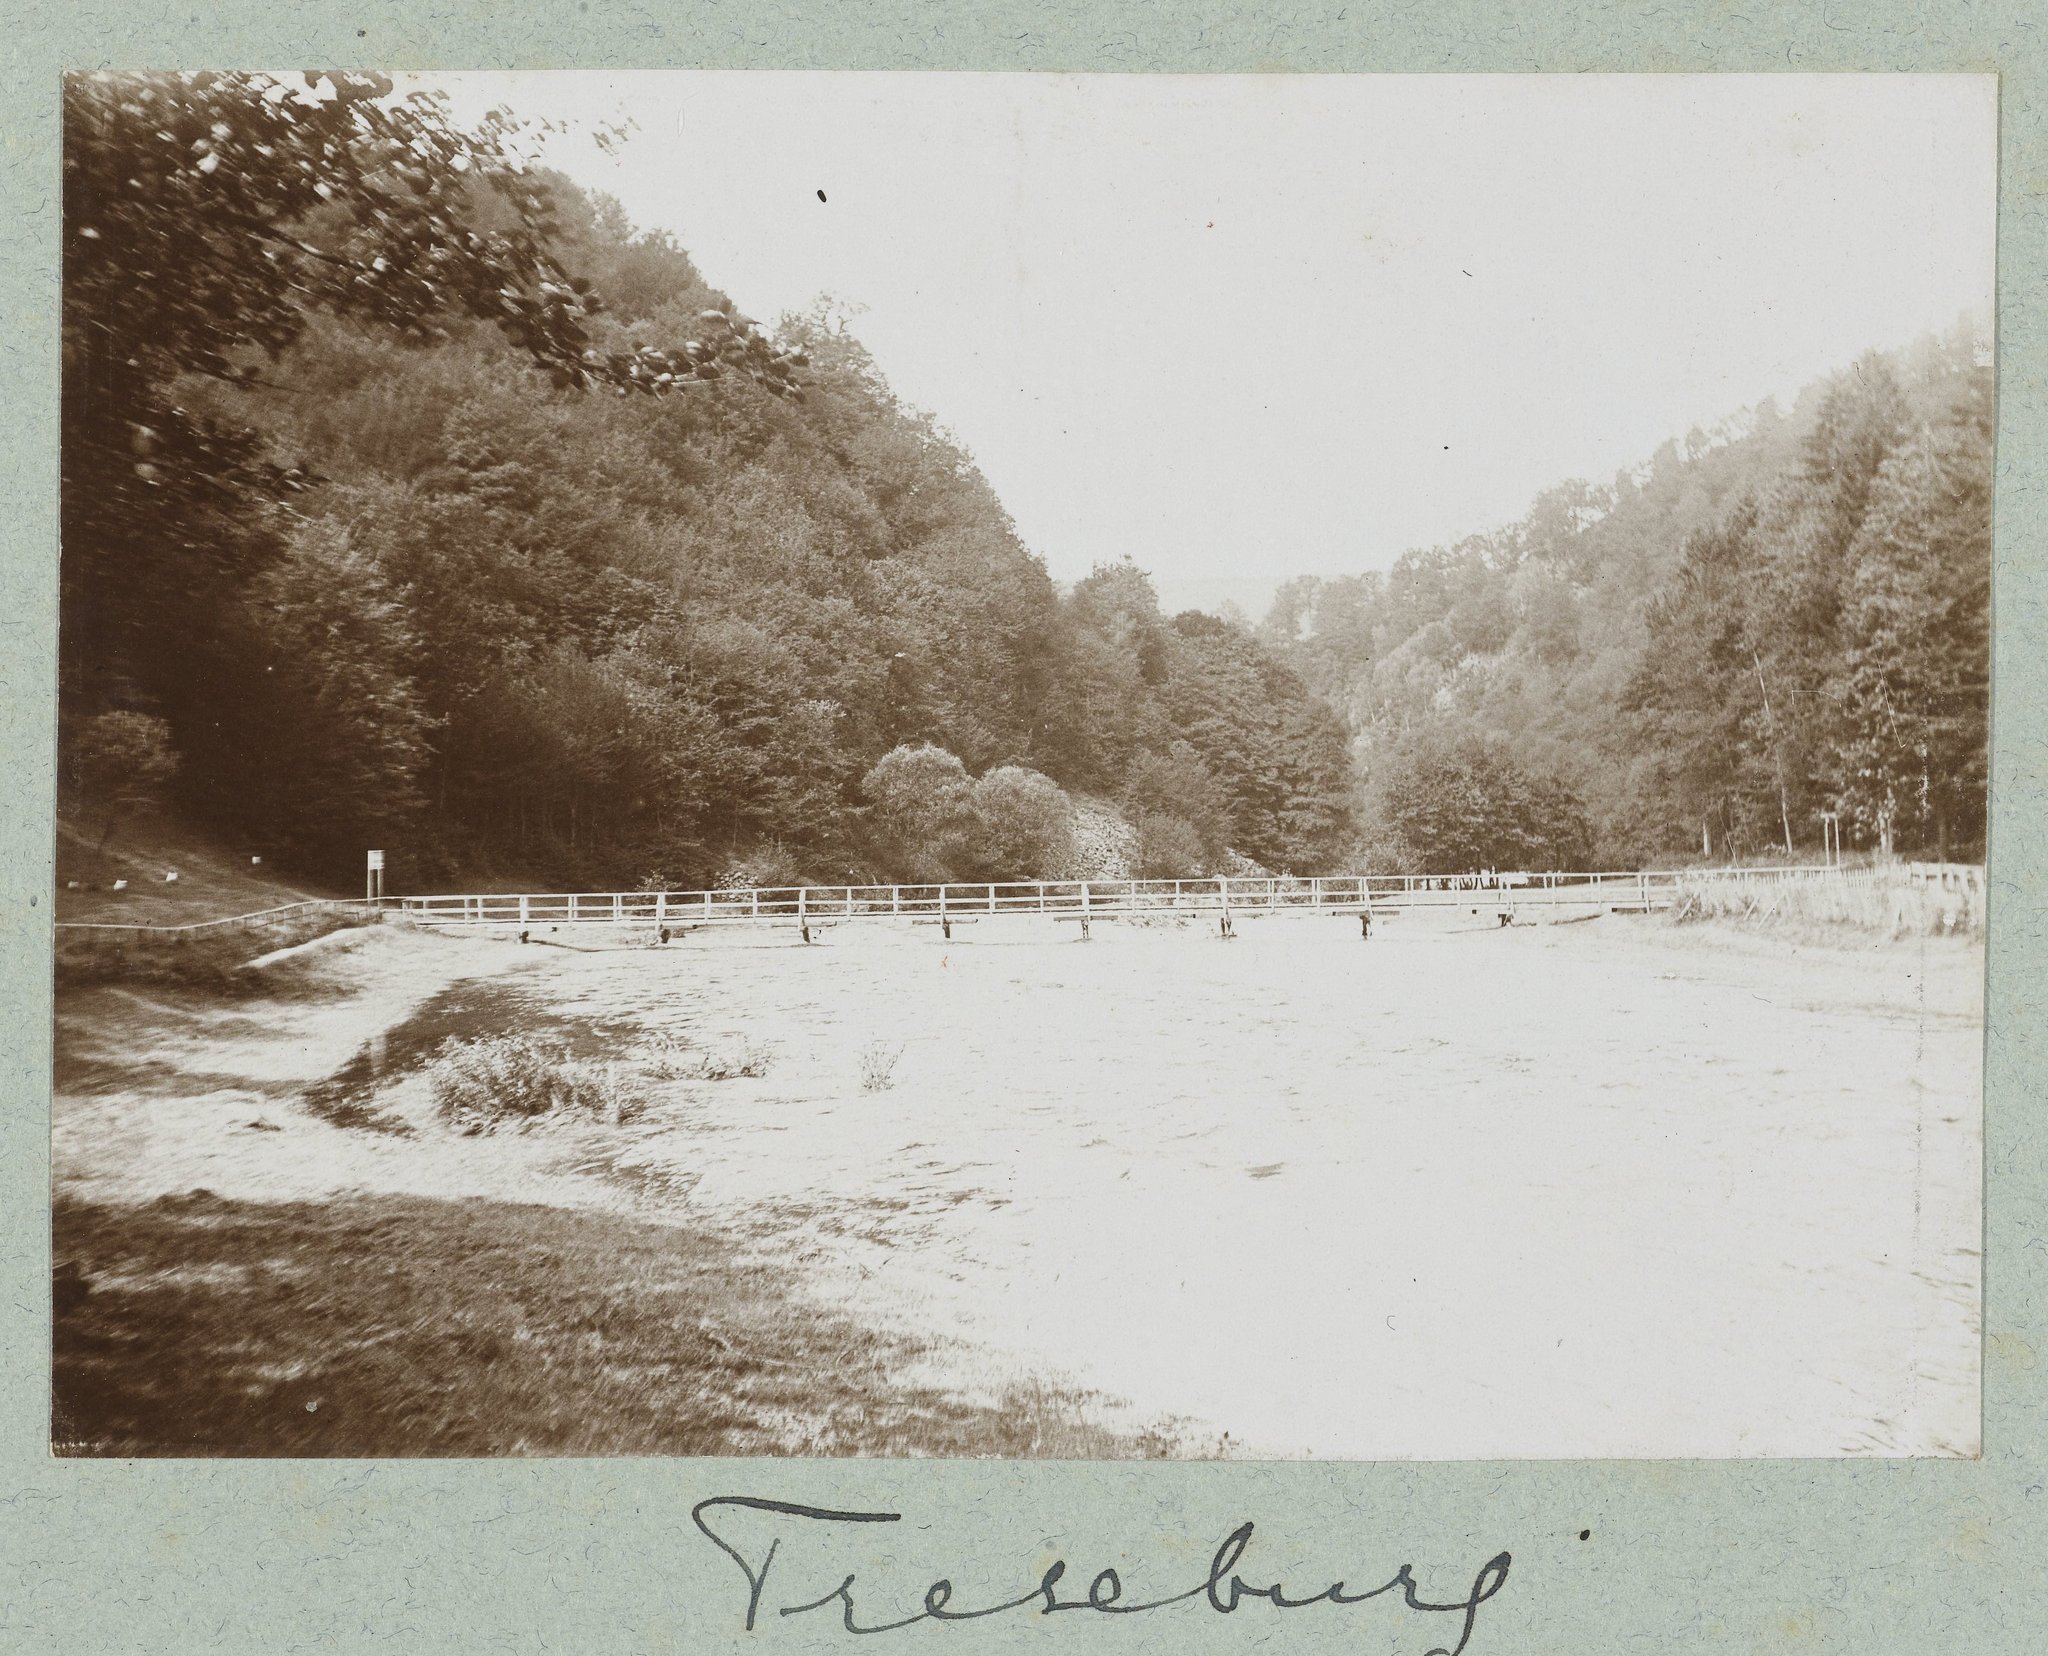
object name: photograph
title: Riviergezicht met op de achtergrond een bebosd berglandschap.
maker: frits freerks fontein fz.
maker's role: fotograaf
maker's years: 1882-1928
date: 1903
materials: cardboard, paper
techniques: gelatin silver print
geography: germany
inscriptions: caption: ‘Harz 1905, Treseburg’